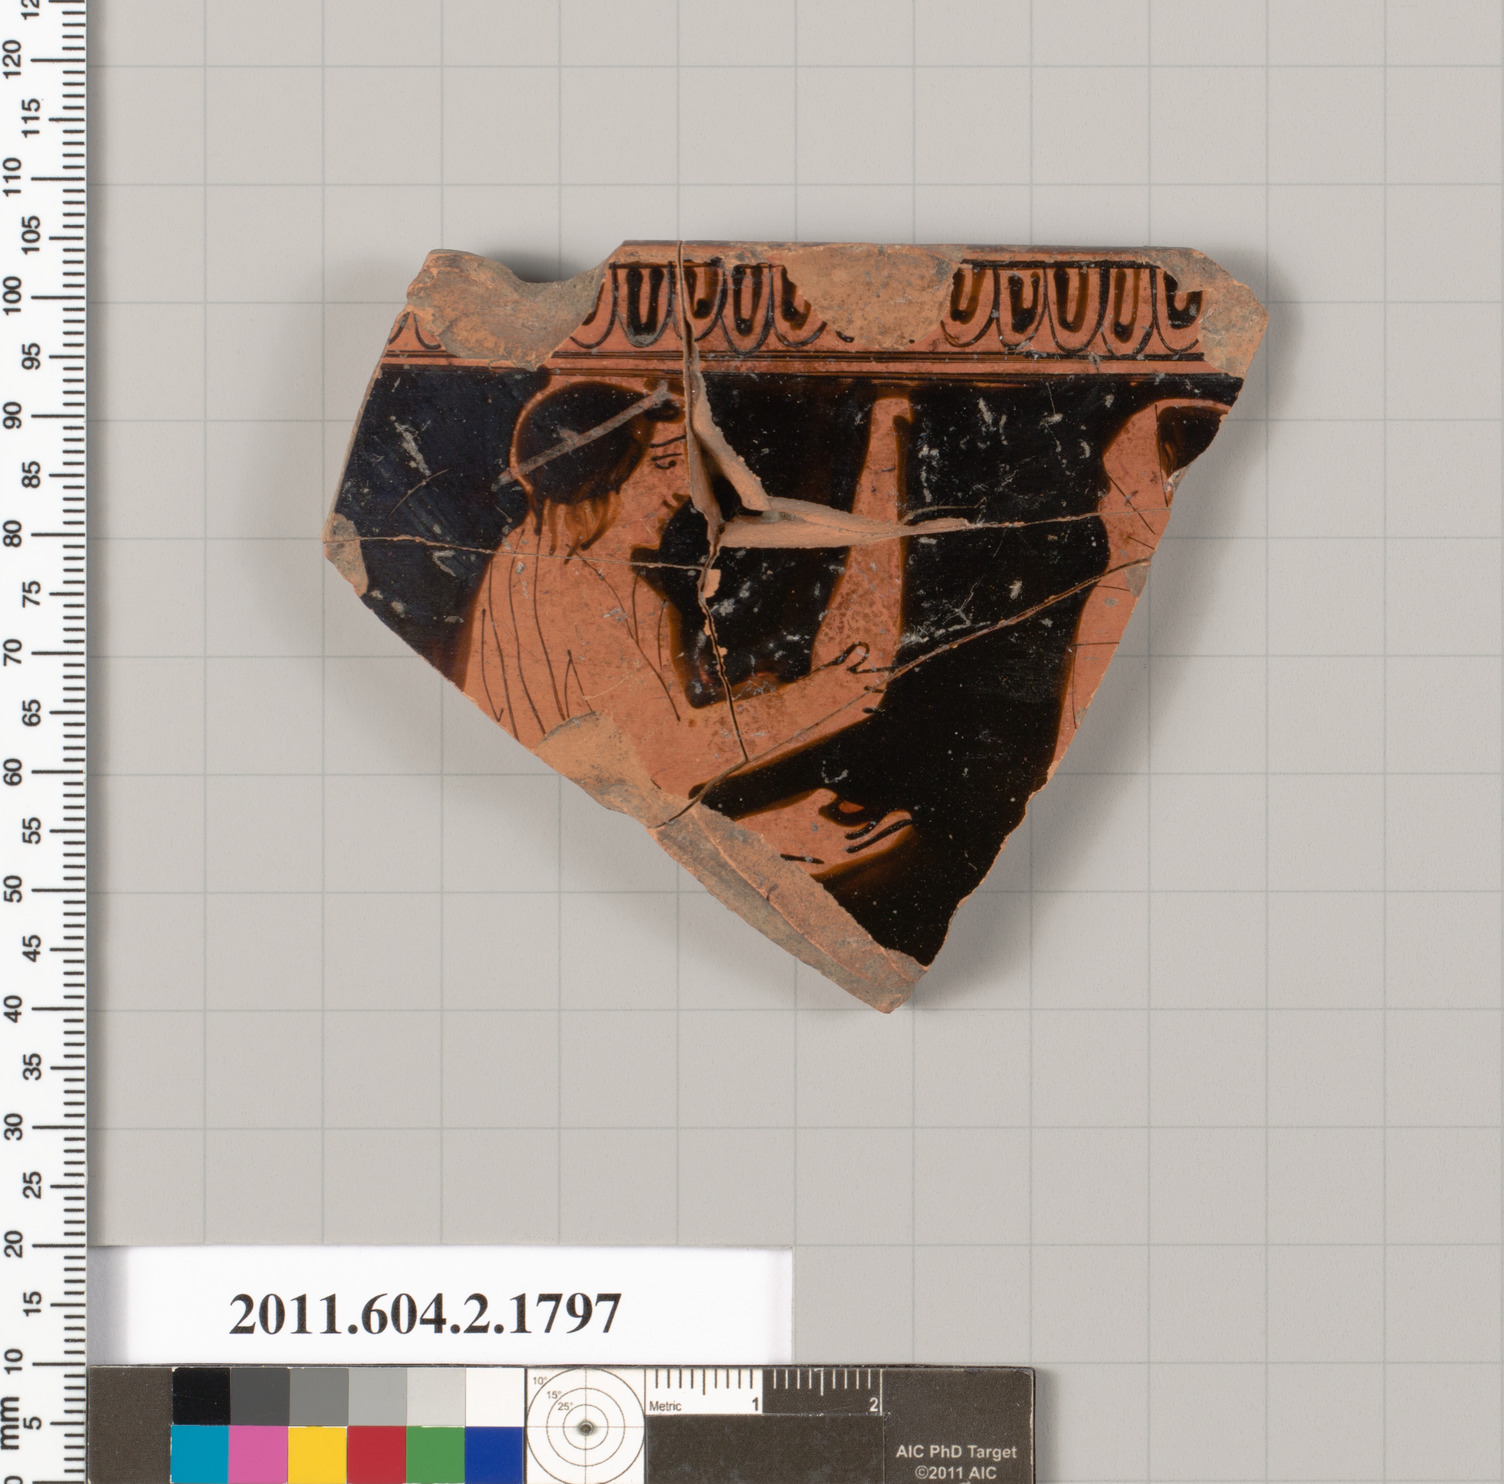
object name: skyphos fragment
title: Terracotta rim fragment of a skyphos (deep drinking cup)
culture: greek, attic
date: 450-426 BCE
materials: terracotta